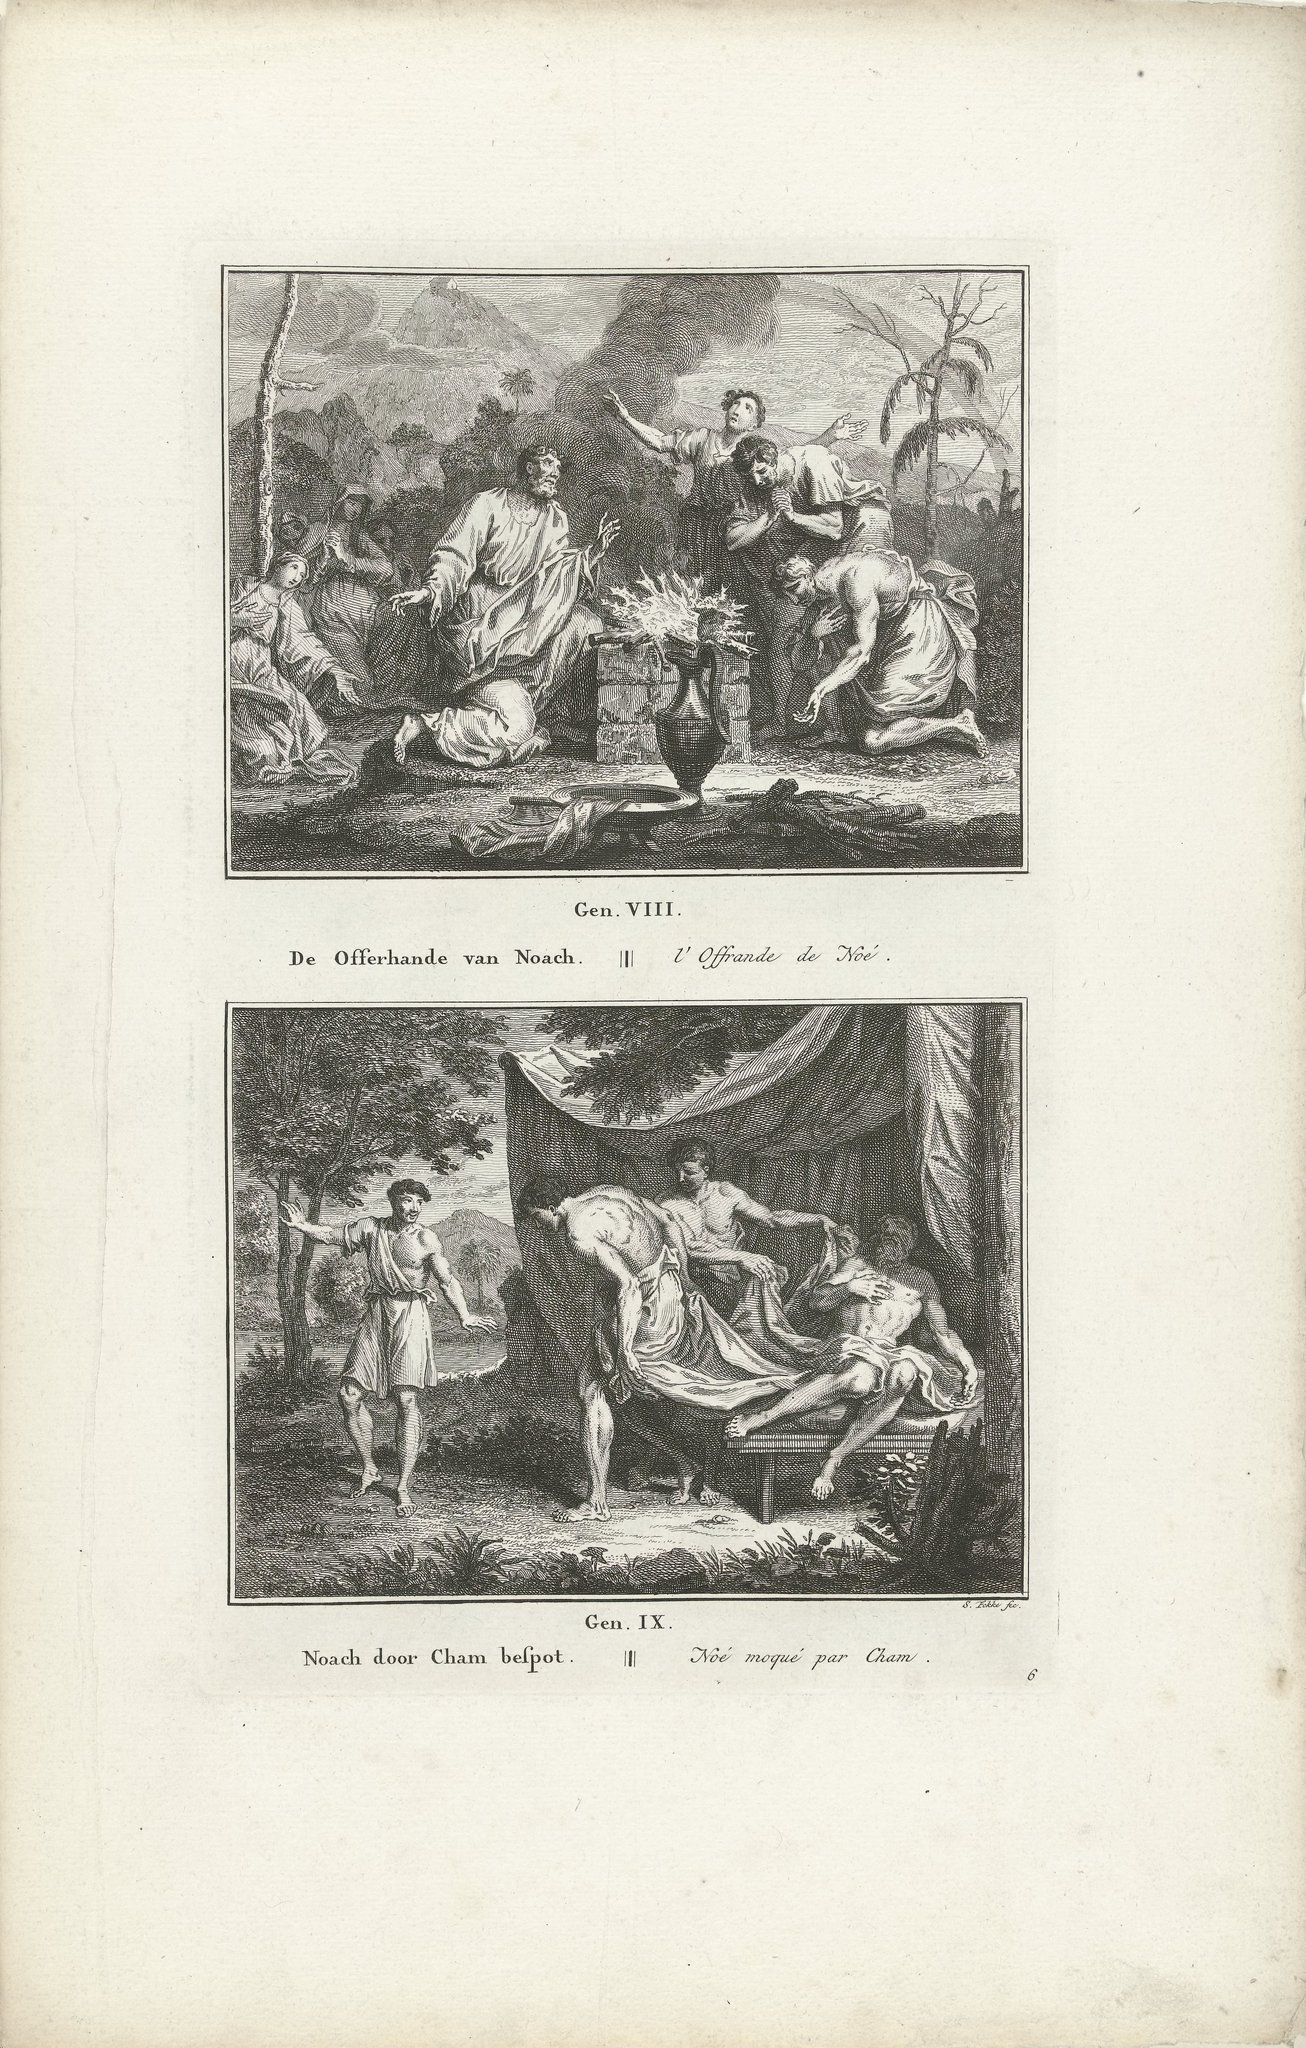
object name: print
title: Offer van Noach en Noach door Cham bespot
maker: simon fokke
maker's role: draughtsman, print maker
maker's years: 1712-1784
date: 1791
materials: paper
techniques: etching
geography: amsterdam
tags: noah's sacrifice; various animals are offered, possibly a lamb, a dove and a ram (often combined with the rainbow of the covenant), the mocking of noah: ham finds his father (partially) naked sleeping out of doors (or in his tent, or in the vineyard cottage); ham calls his brothers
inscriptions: collector's mark: Lugt 2233, collector's mark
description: Twee Bijbelse voorstellingen uit Gen. 8 en 9. Genummerd rechtsonder: 6.